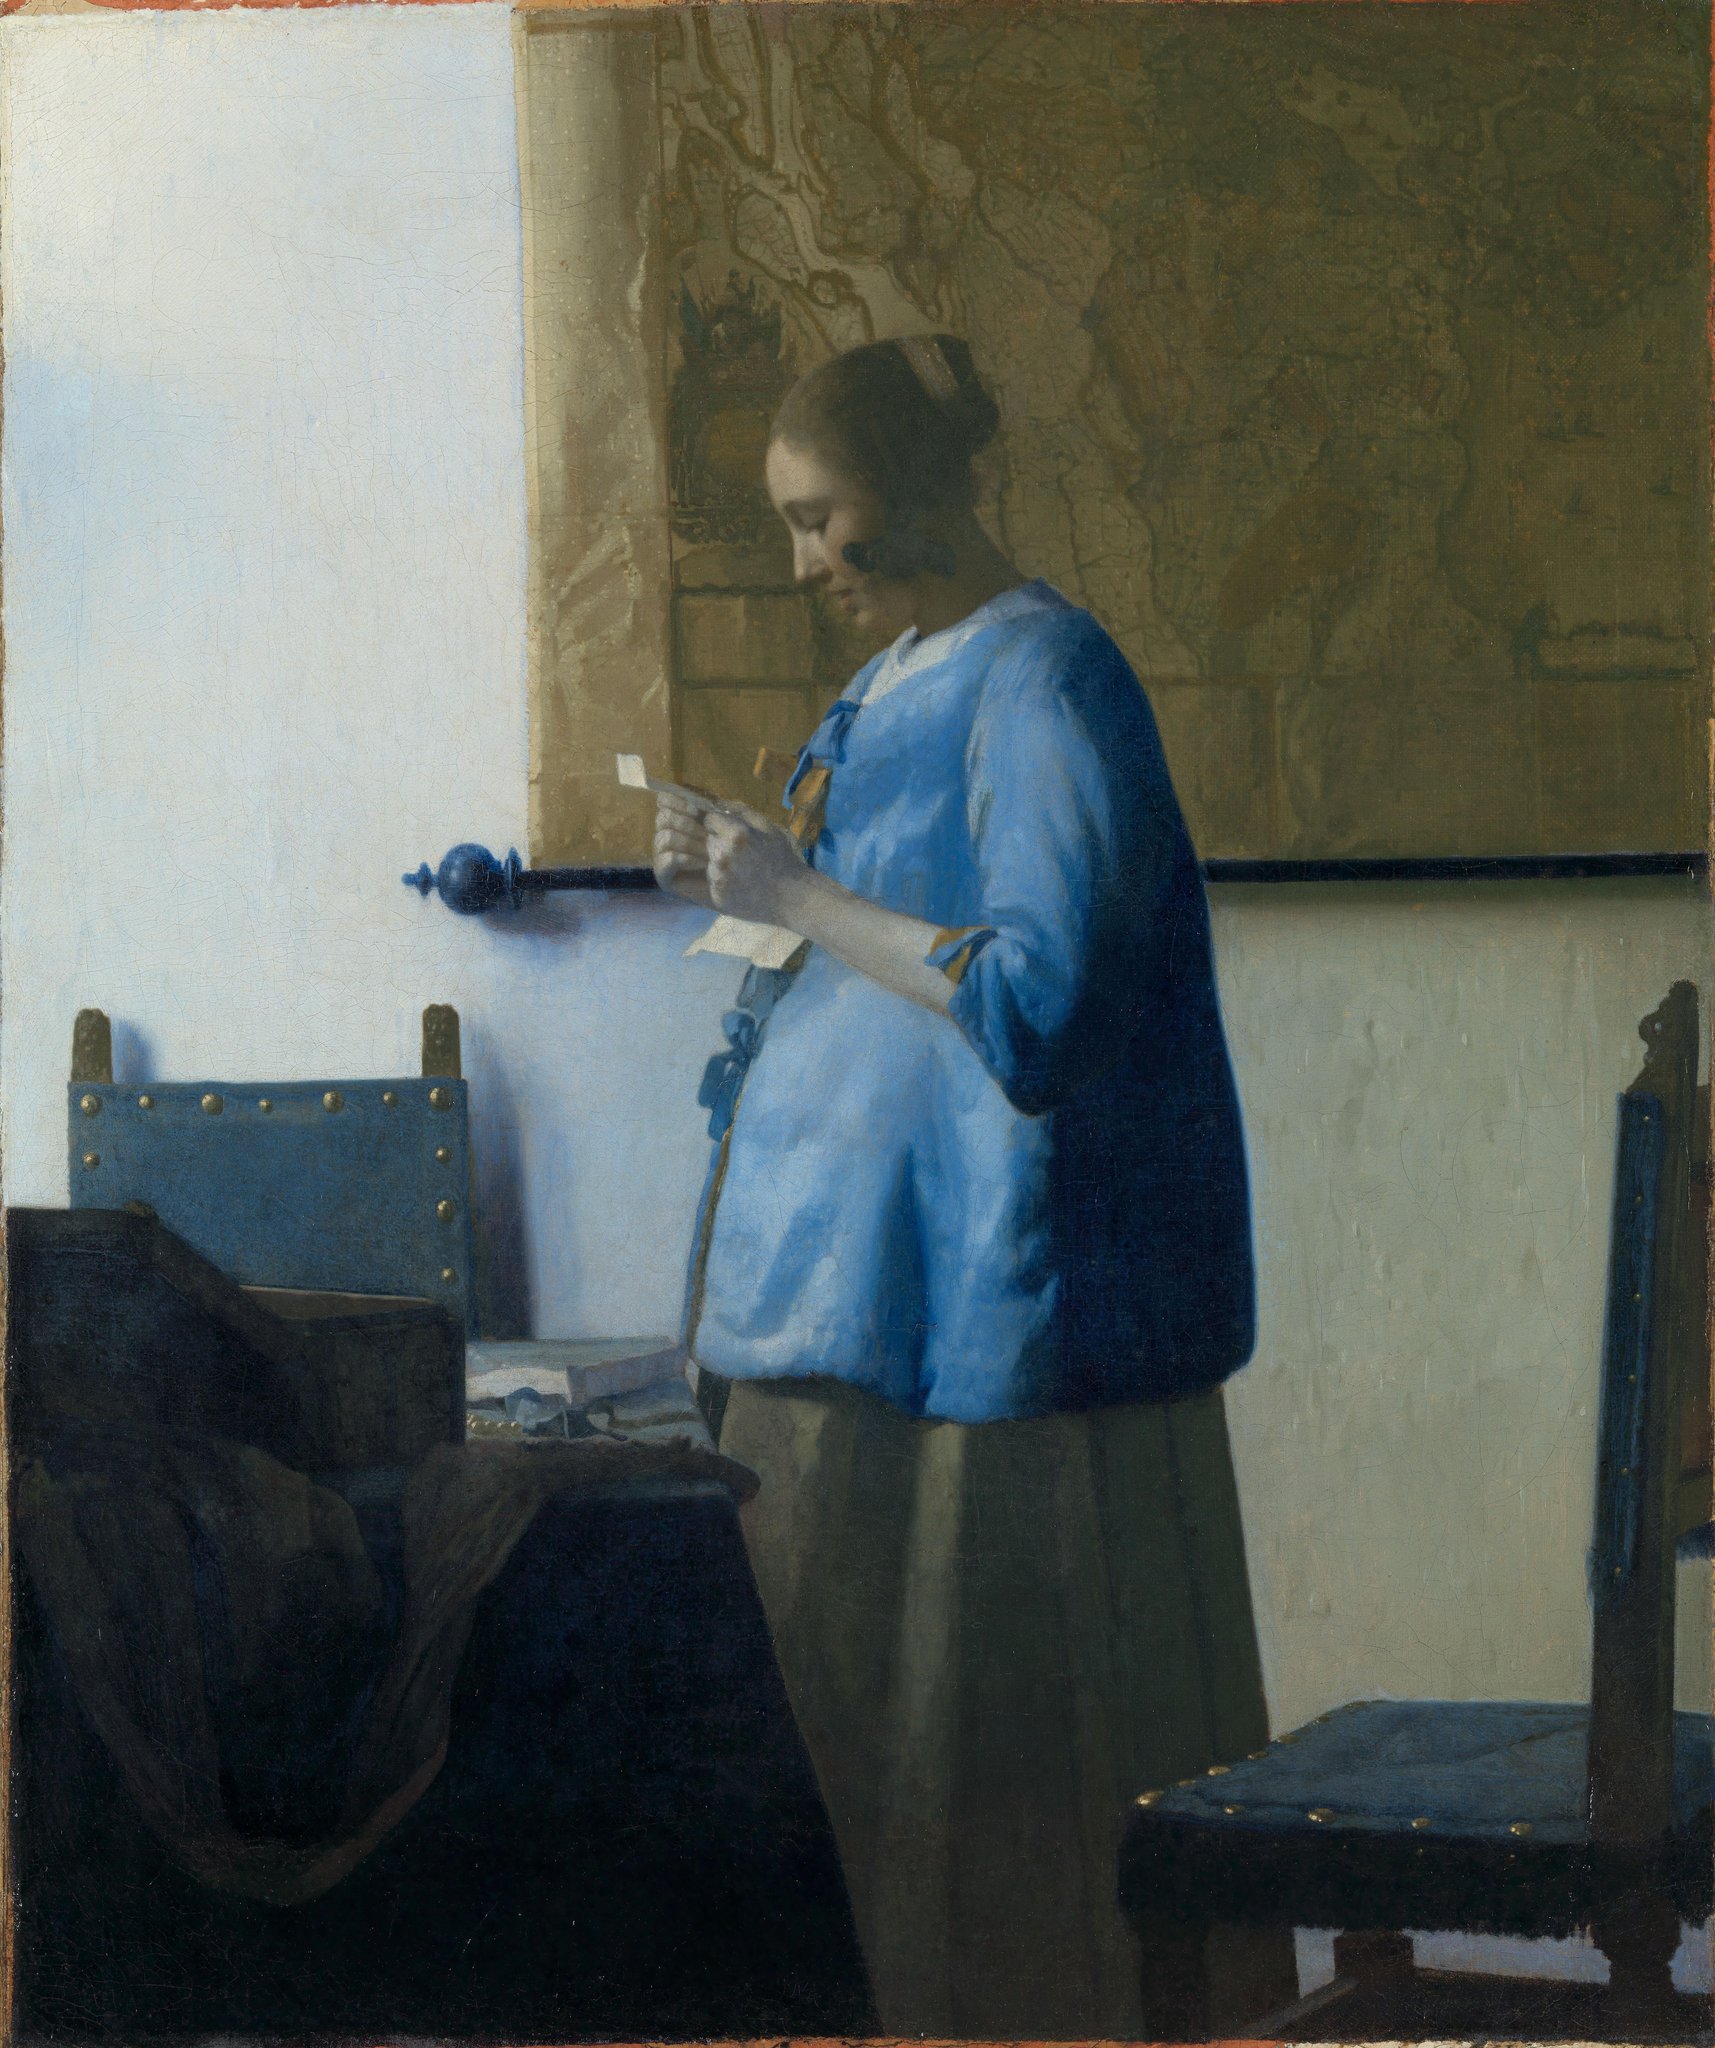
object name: painting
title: Woman in Blue Reading a Letter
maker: johannes vermeer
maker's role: draughtsman, painter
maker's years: 1632-1675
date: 1663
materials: canvas, oil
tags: reading, maps, atlases, letter, envelope, chair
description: Enjoying a quiet, private moment, this young woman is absorbed in reading a letter in the morning light. She is still wearing her blue night jacket. All of the colours in the composition are secondary to its radiant lapis lazuli blue. Vermeer recorded the effects of light with extraordinary precision. Particularly innovative is his rendering of the woman’s skin with pale grey, and the shadows on the wall using light blue.